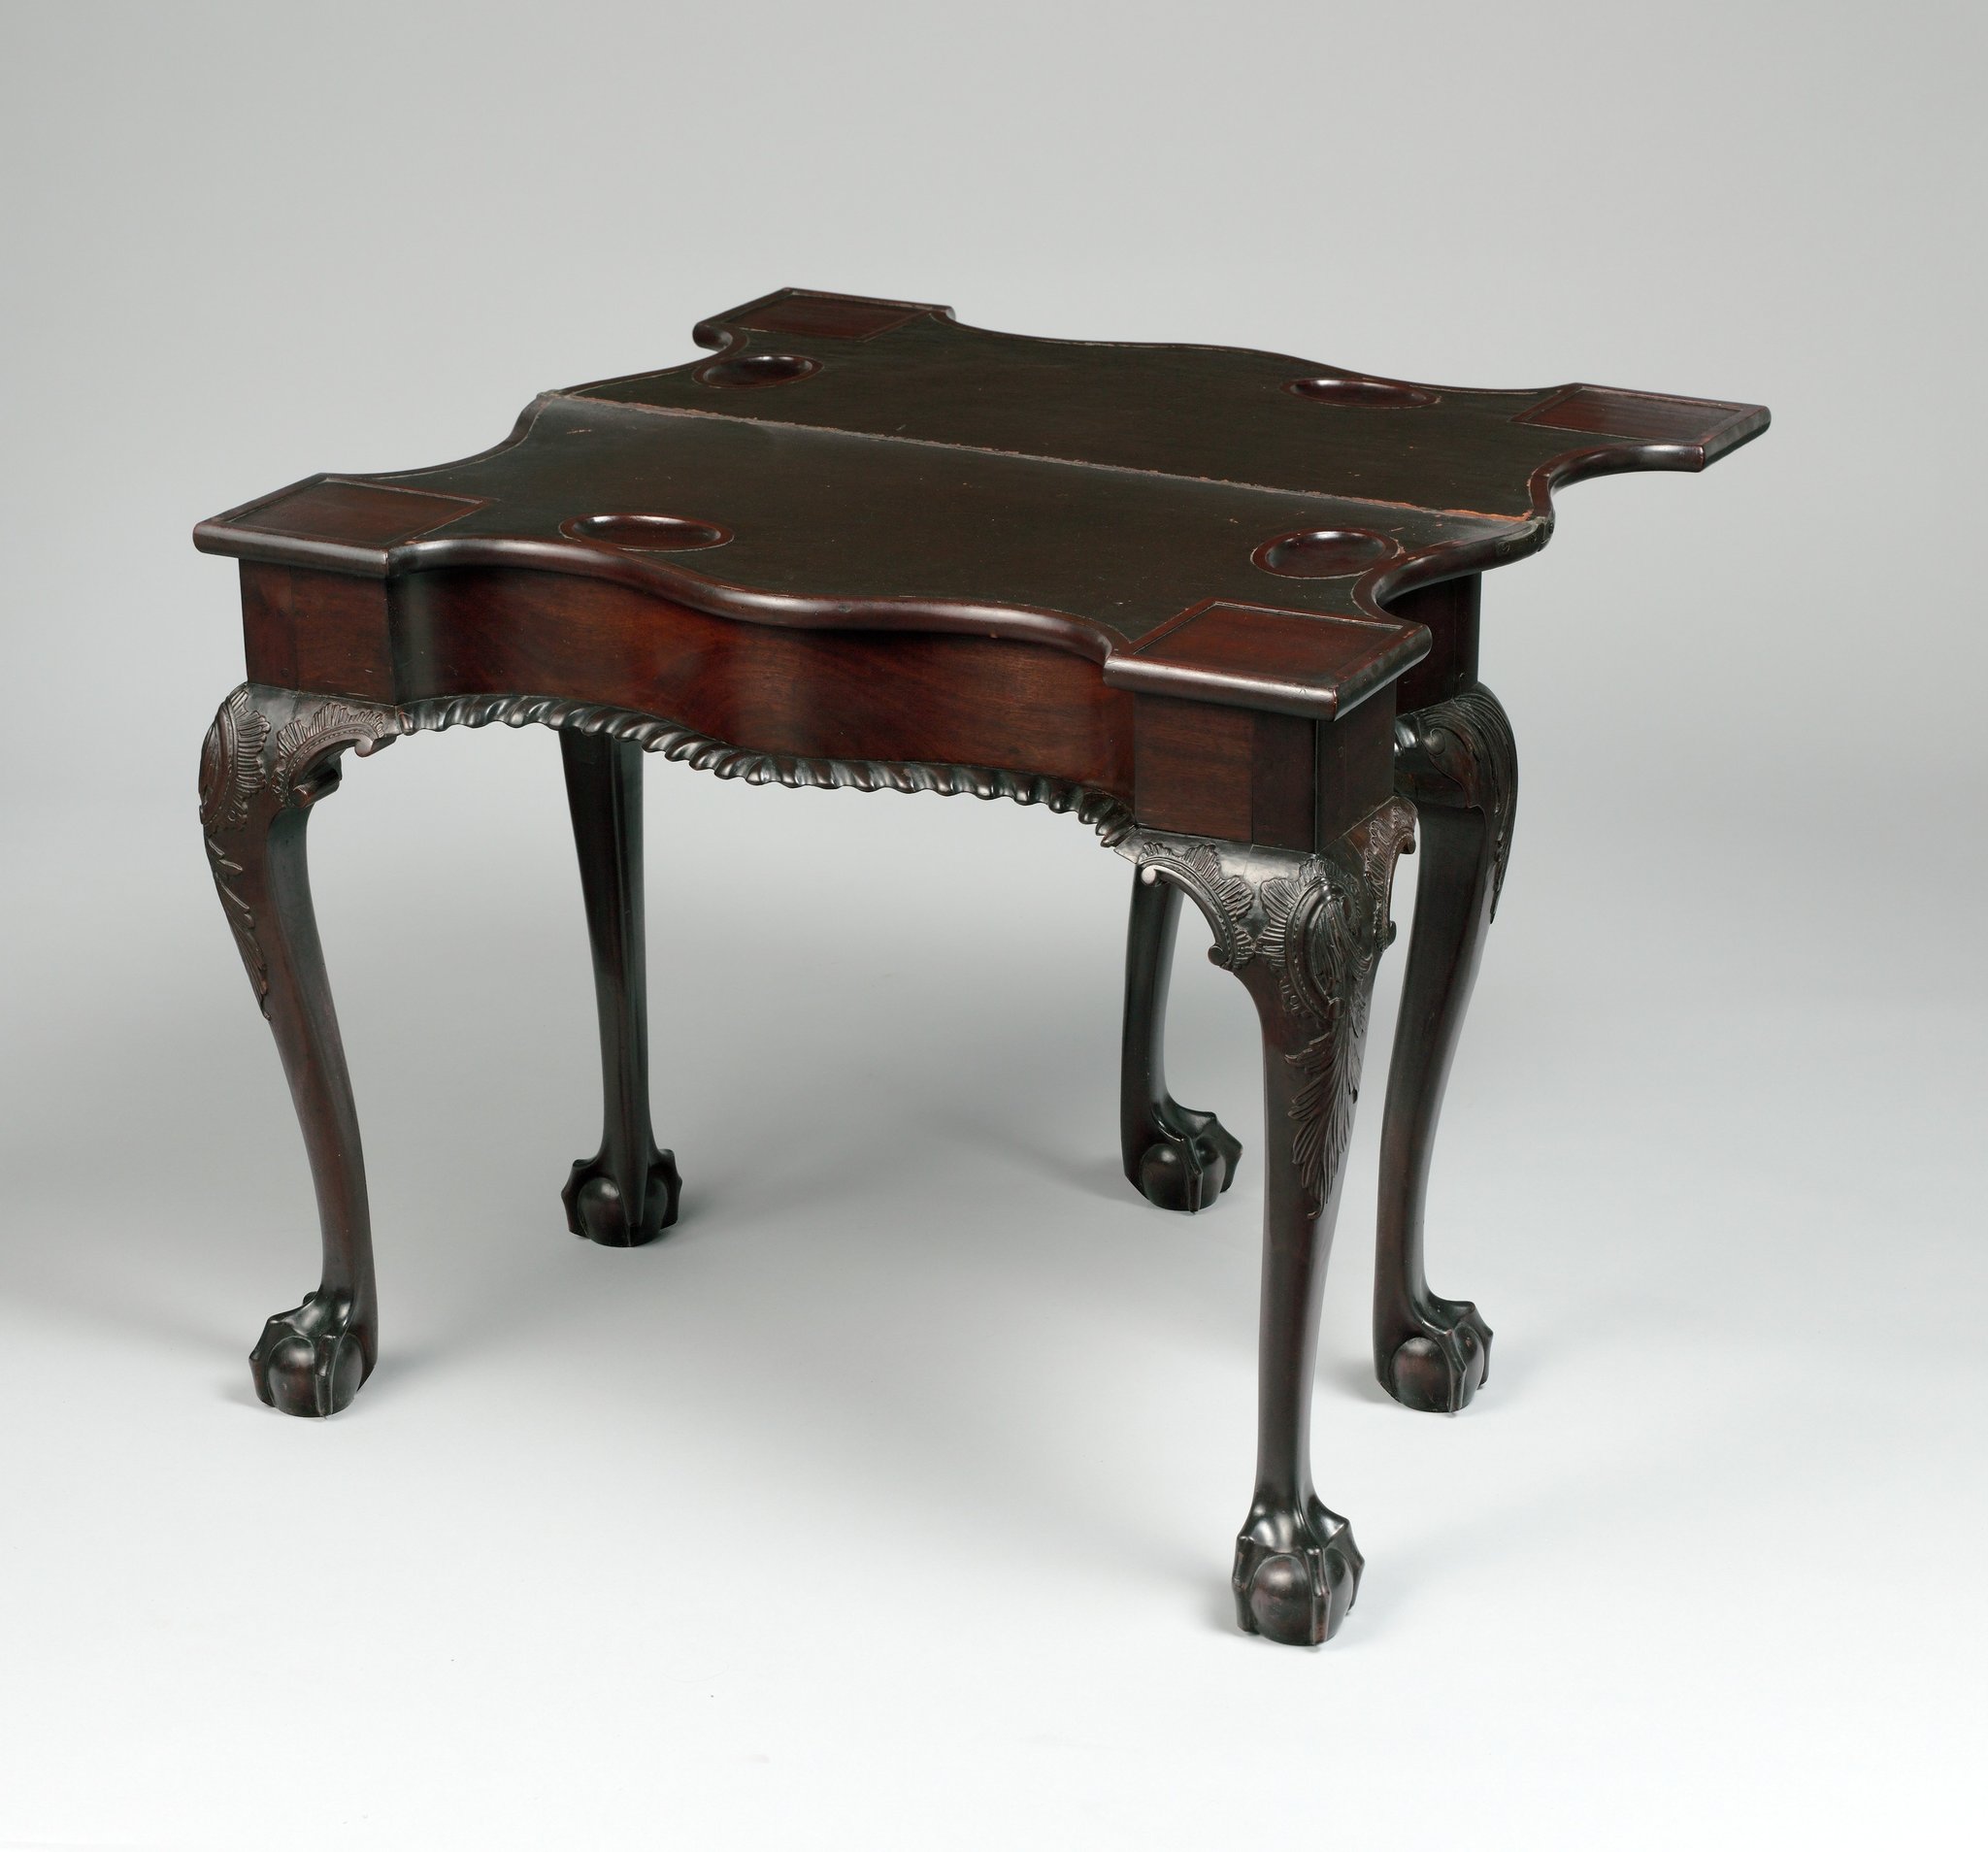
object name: card table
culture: american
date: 1760-1790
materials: wood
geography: united states